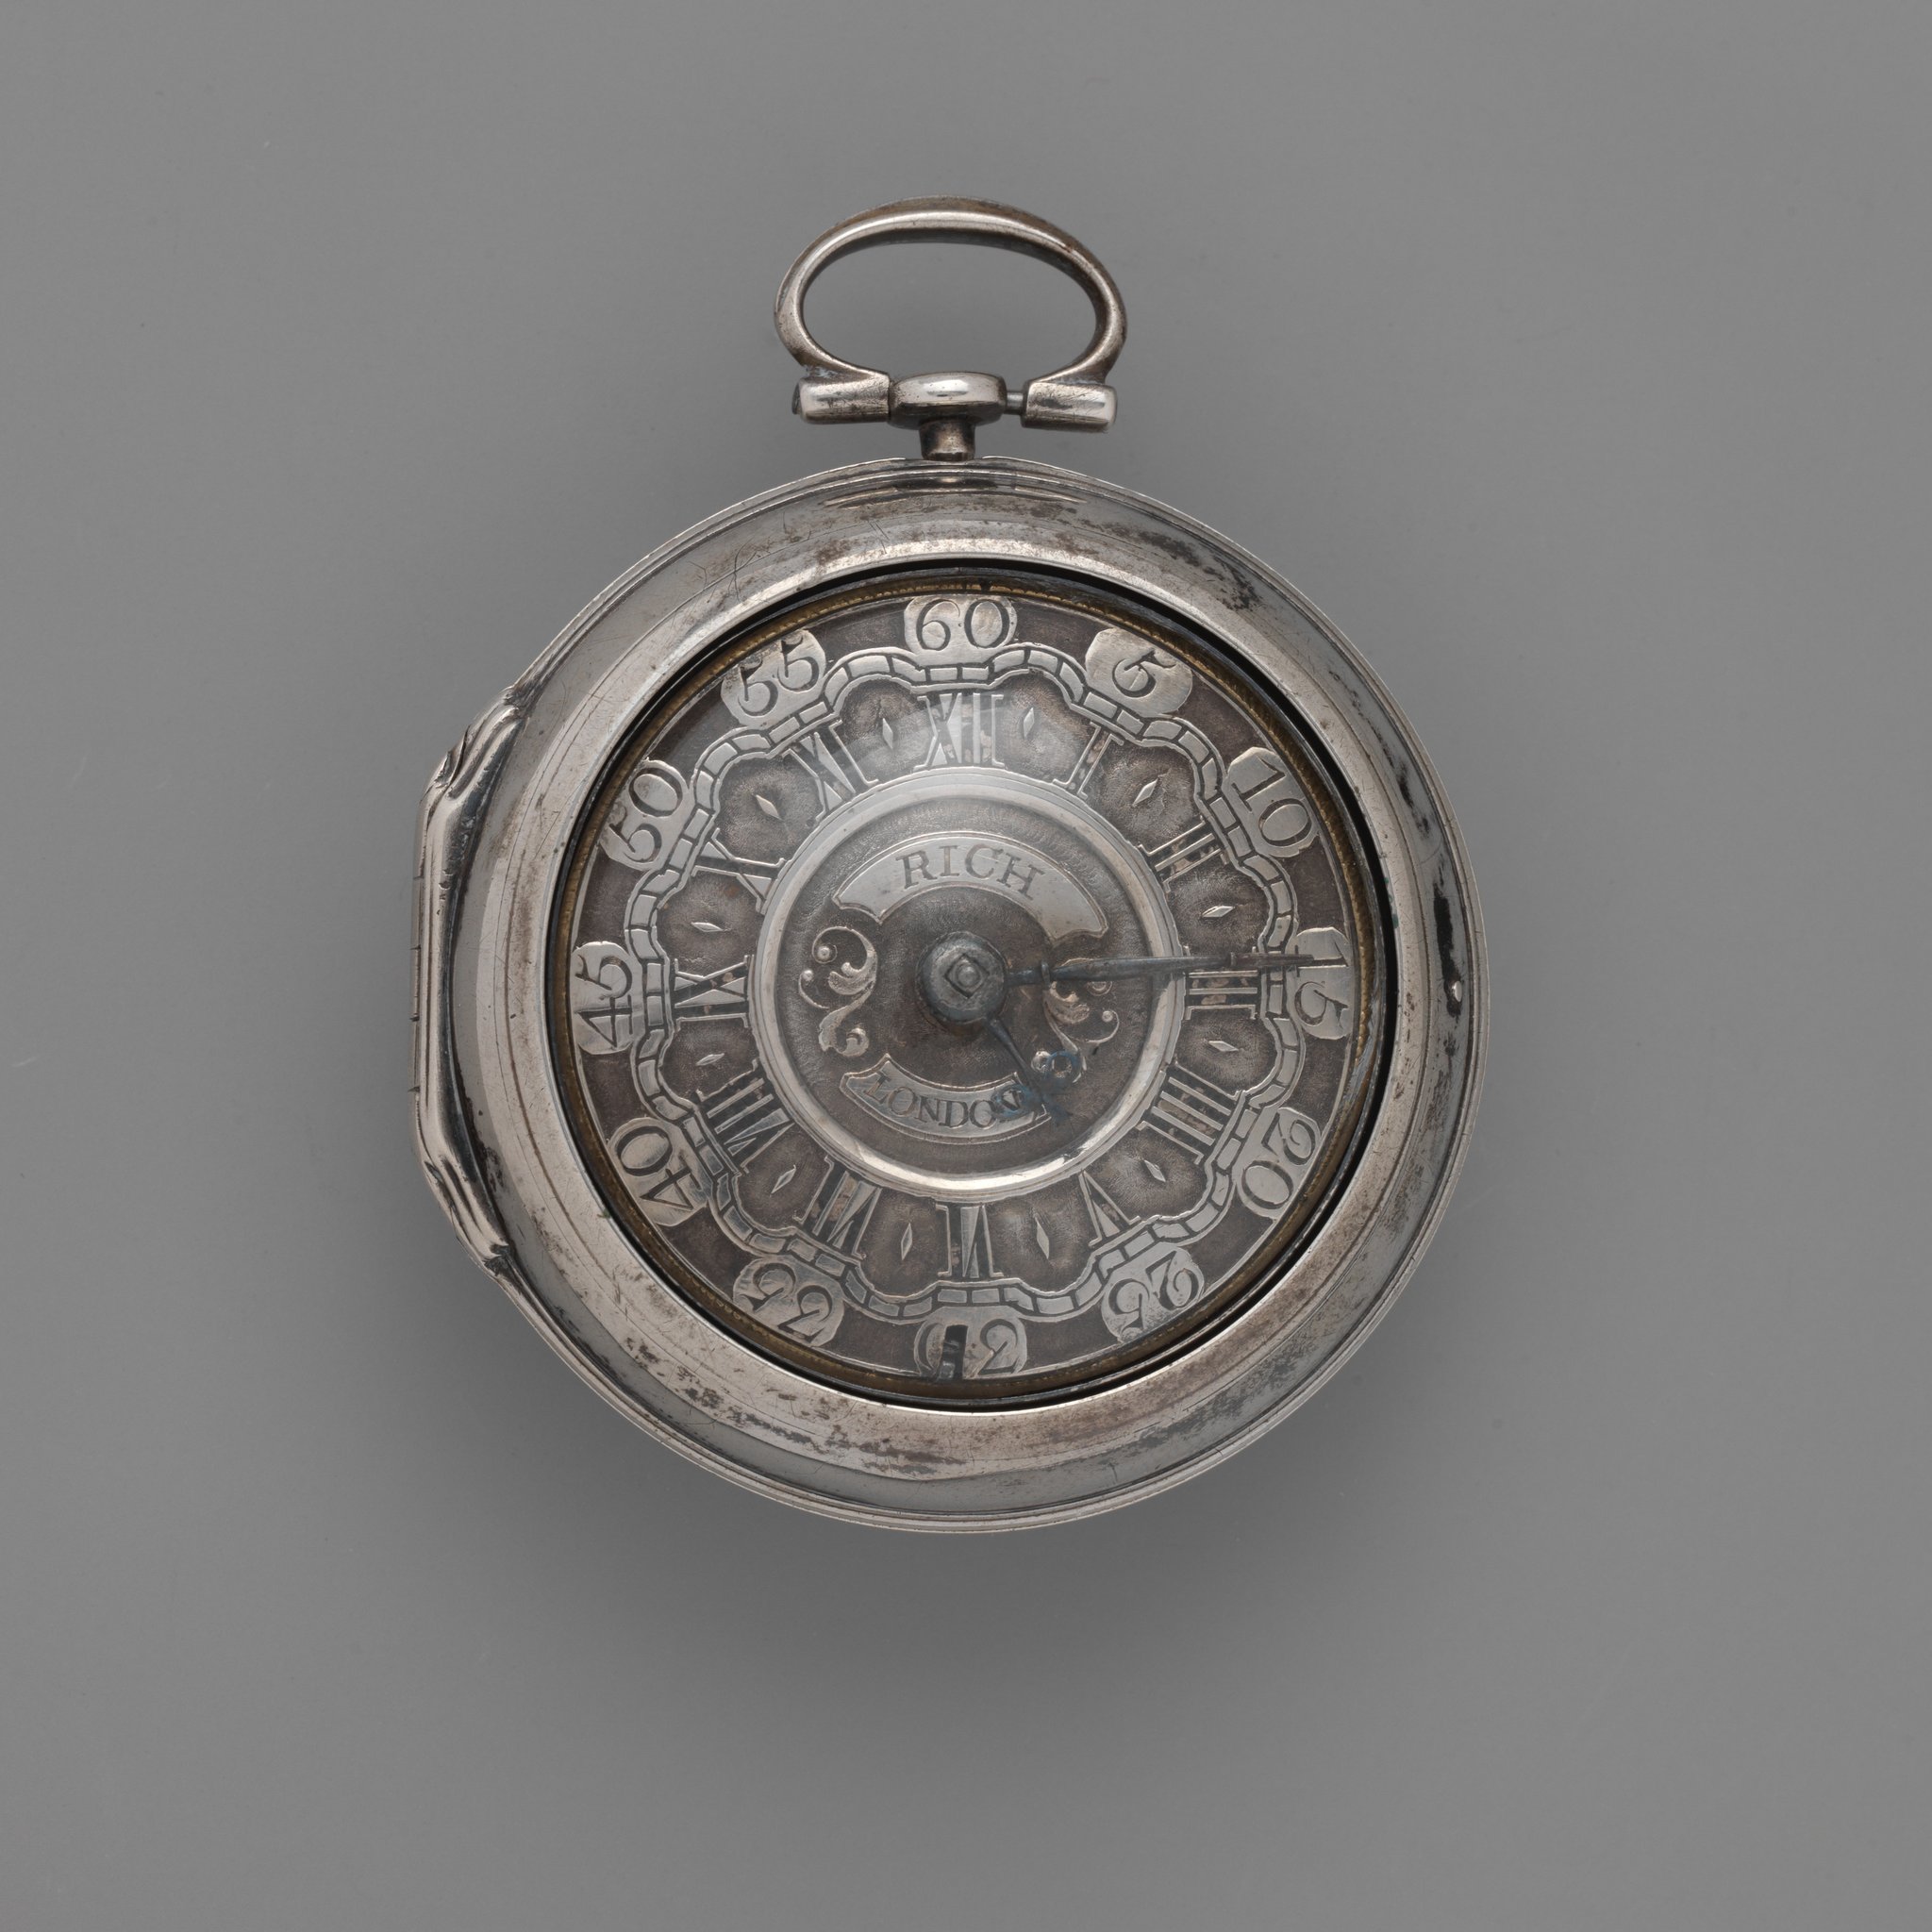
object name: watch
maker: john rich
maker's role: maker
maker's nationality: british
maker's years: 1735-1775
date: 1751-1752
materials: silver